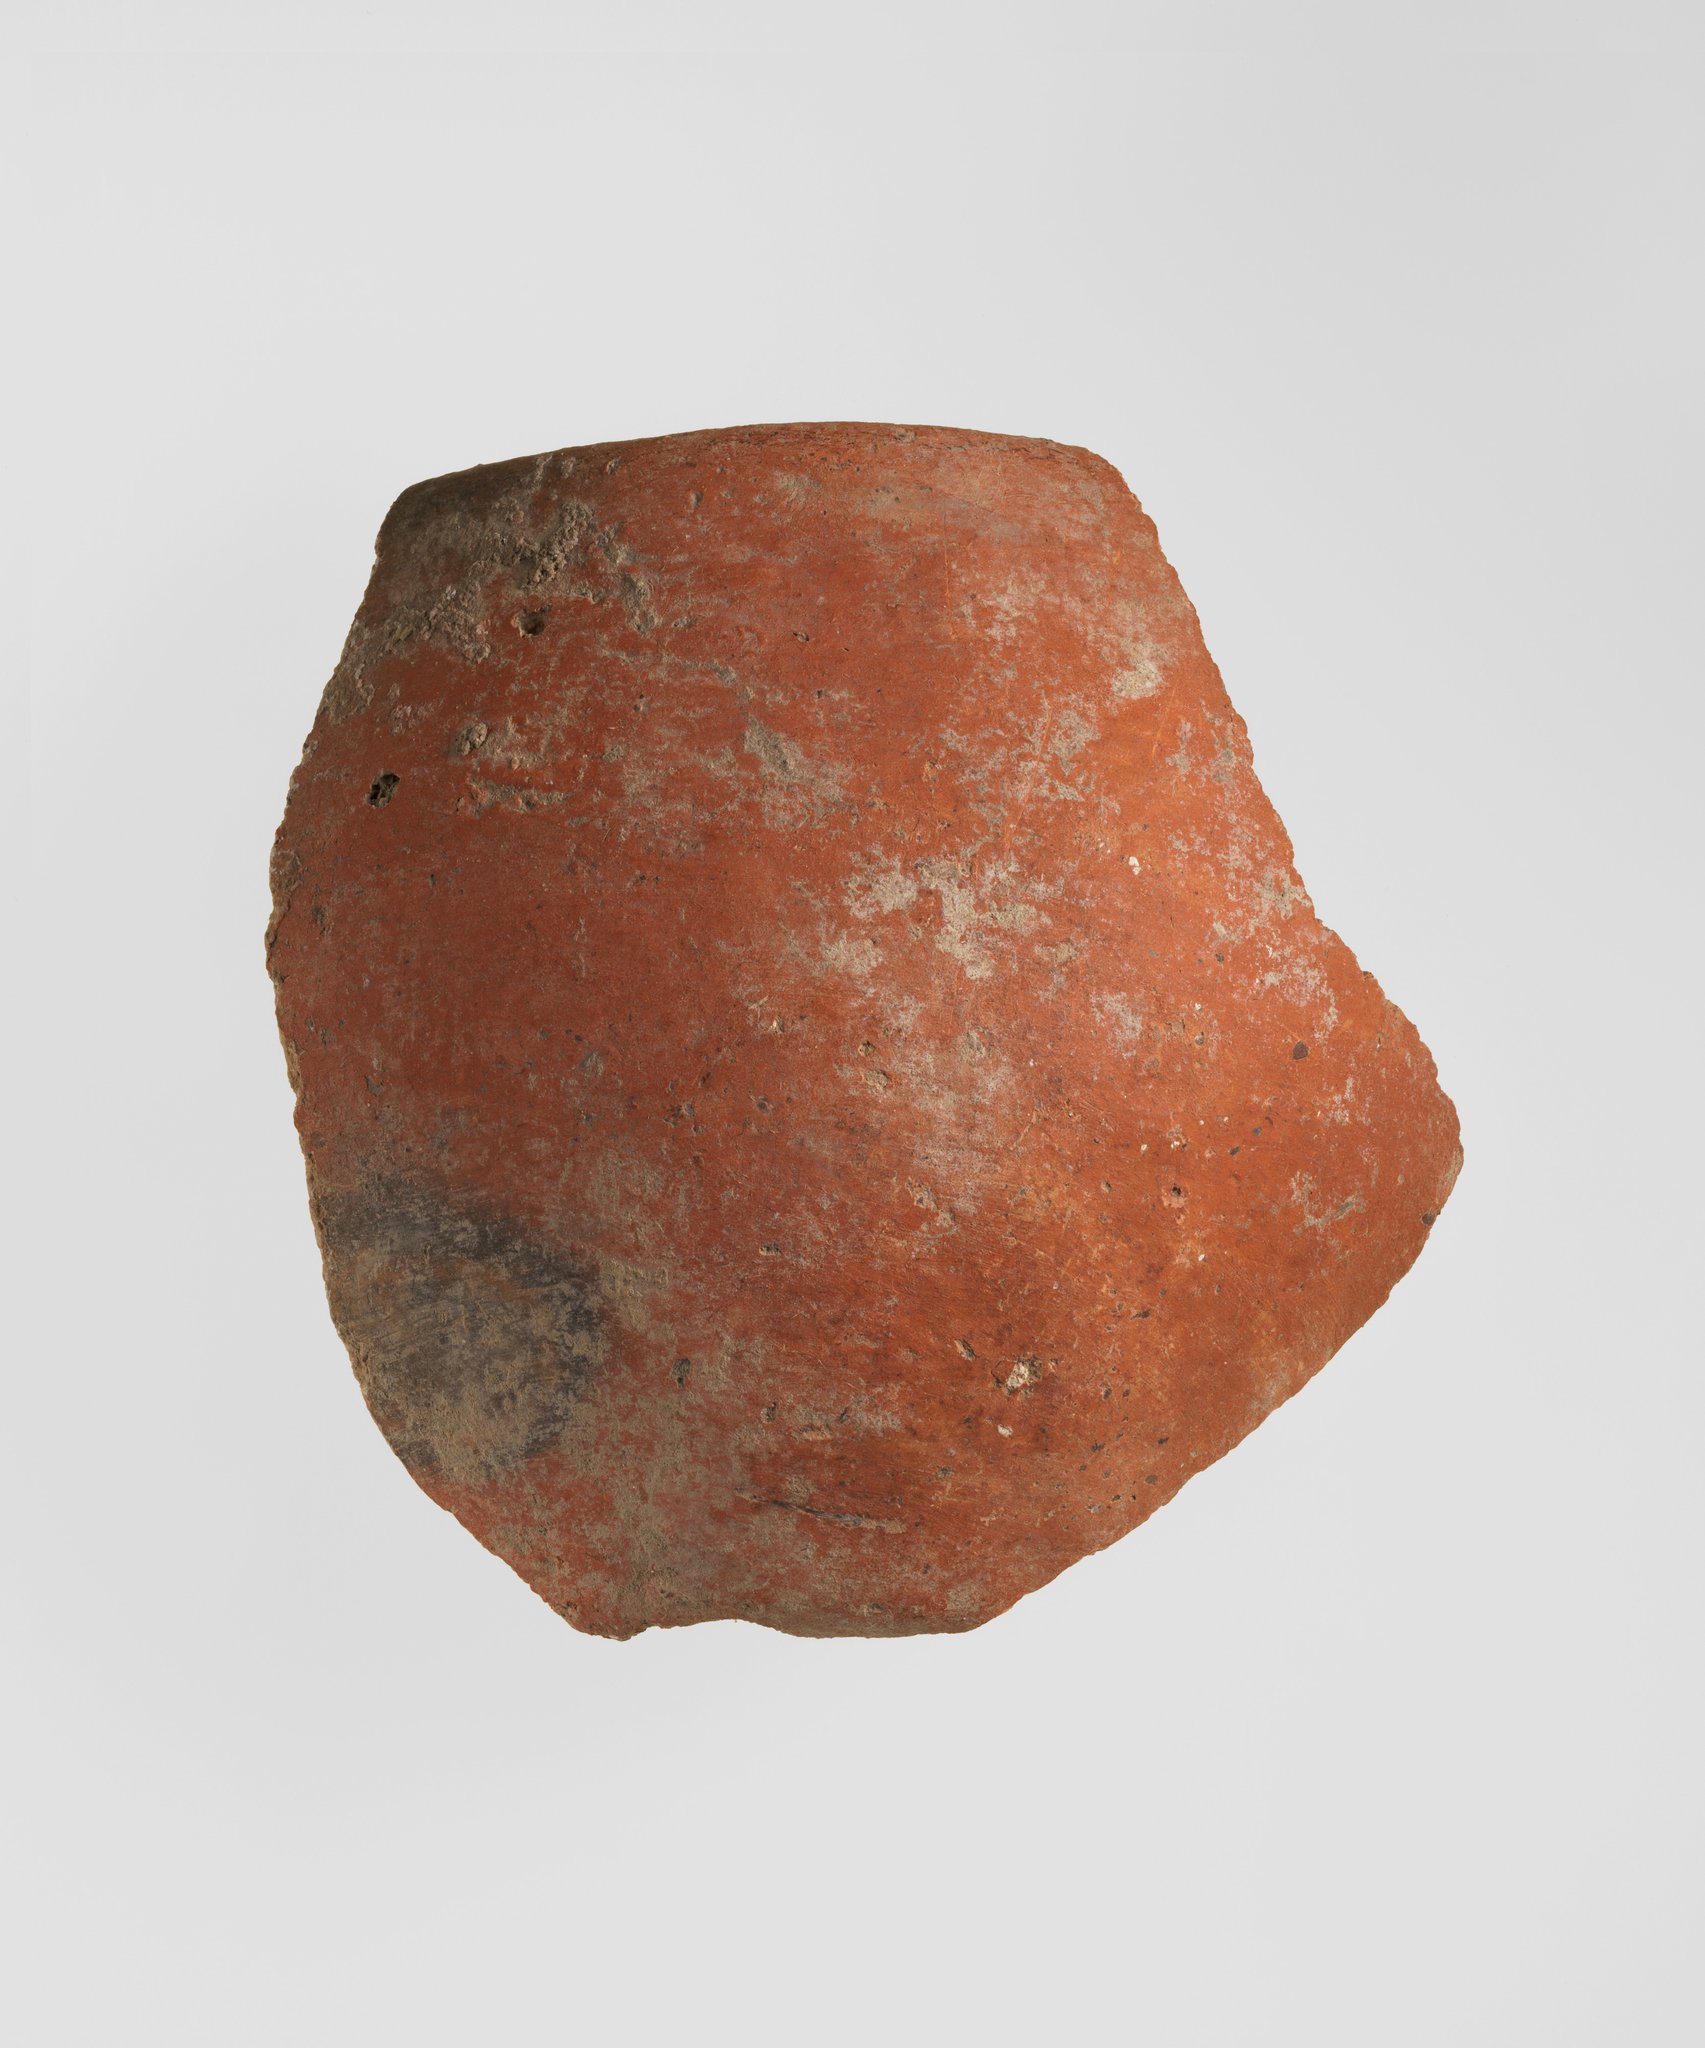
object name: sherd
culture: iranian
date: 3100-2500 BCE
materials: ceramic, paint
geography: iran